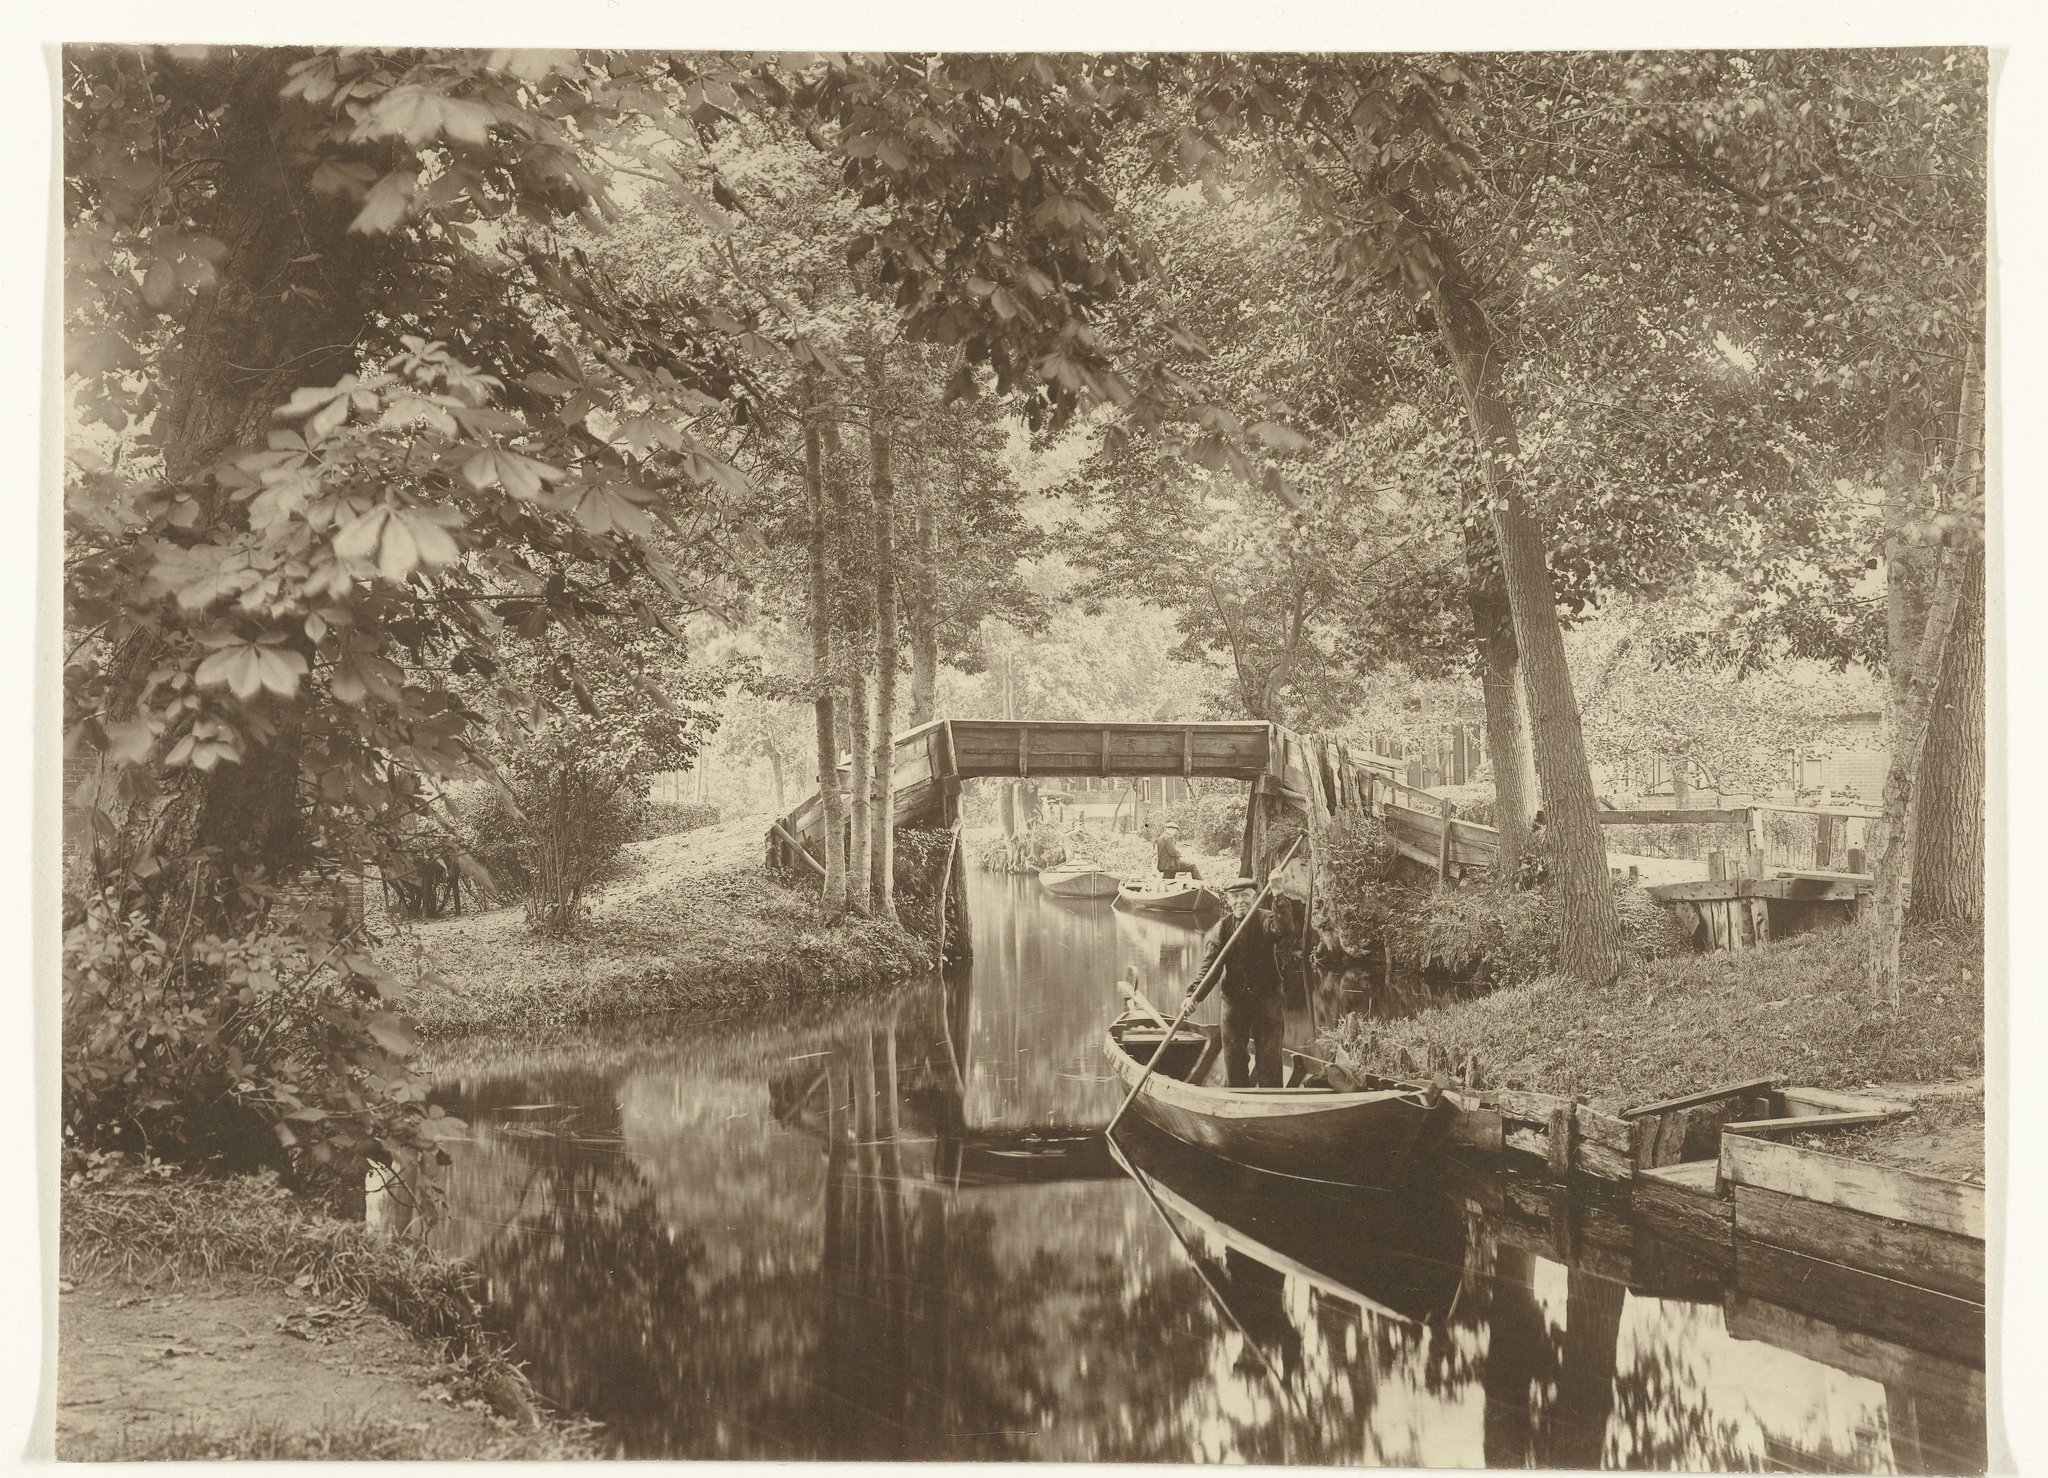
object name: photograph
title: Man vaart in een punter in Giethoorn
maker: richard tepe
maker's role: fotograaf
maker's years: 1864-1952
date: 1900-1930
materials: photographic support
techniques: gelatin silver print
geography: netherlands